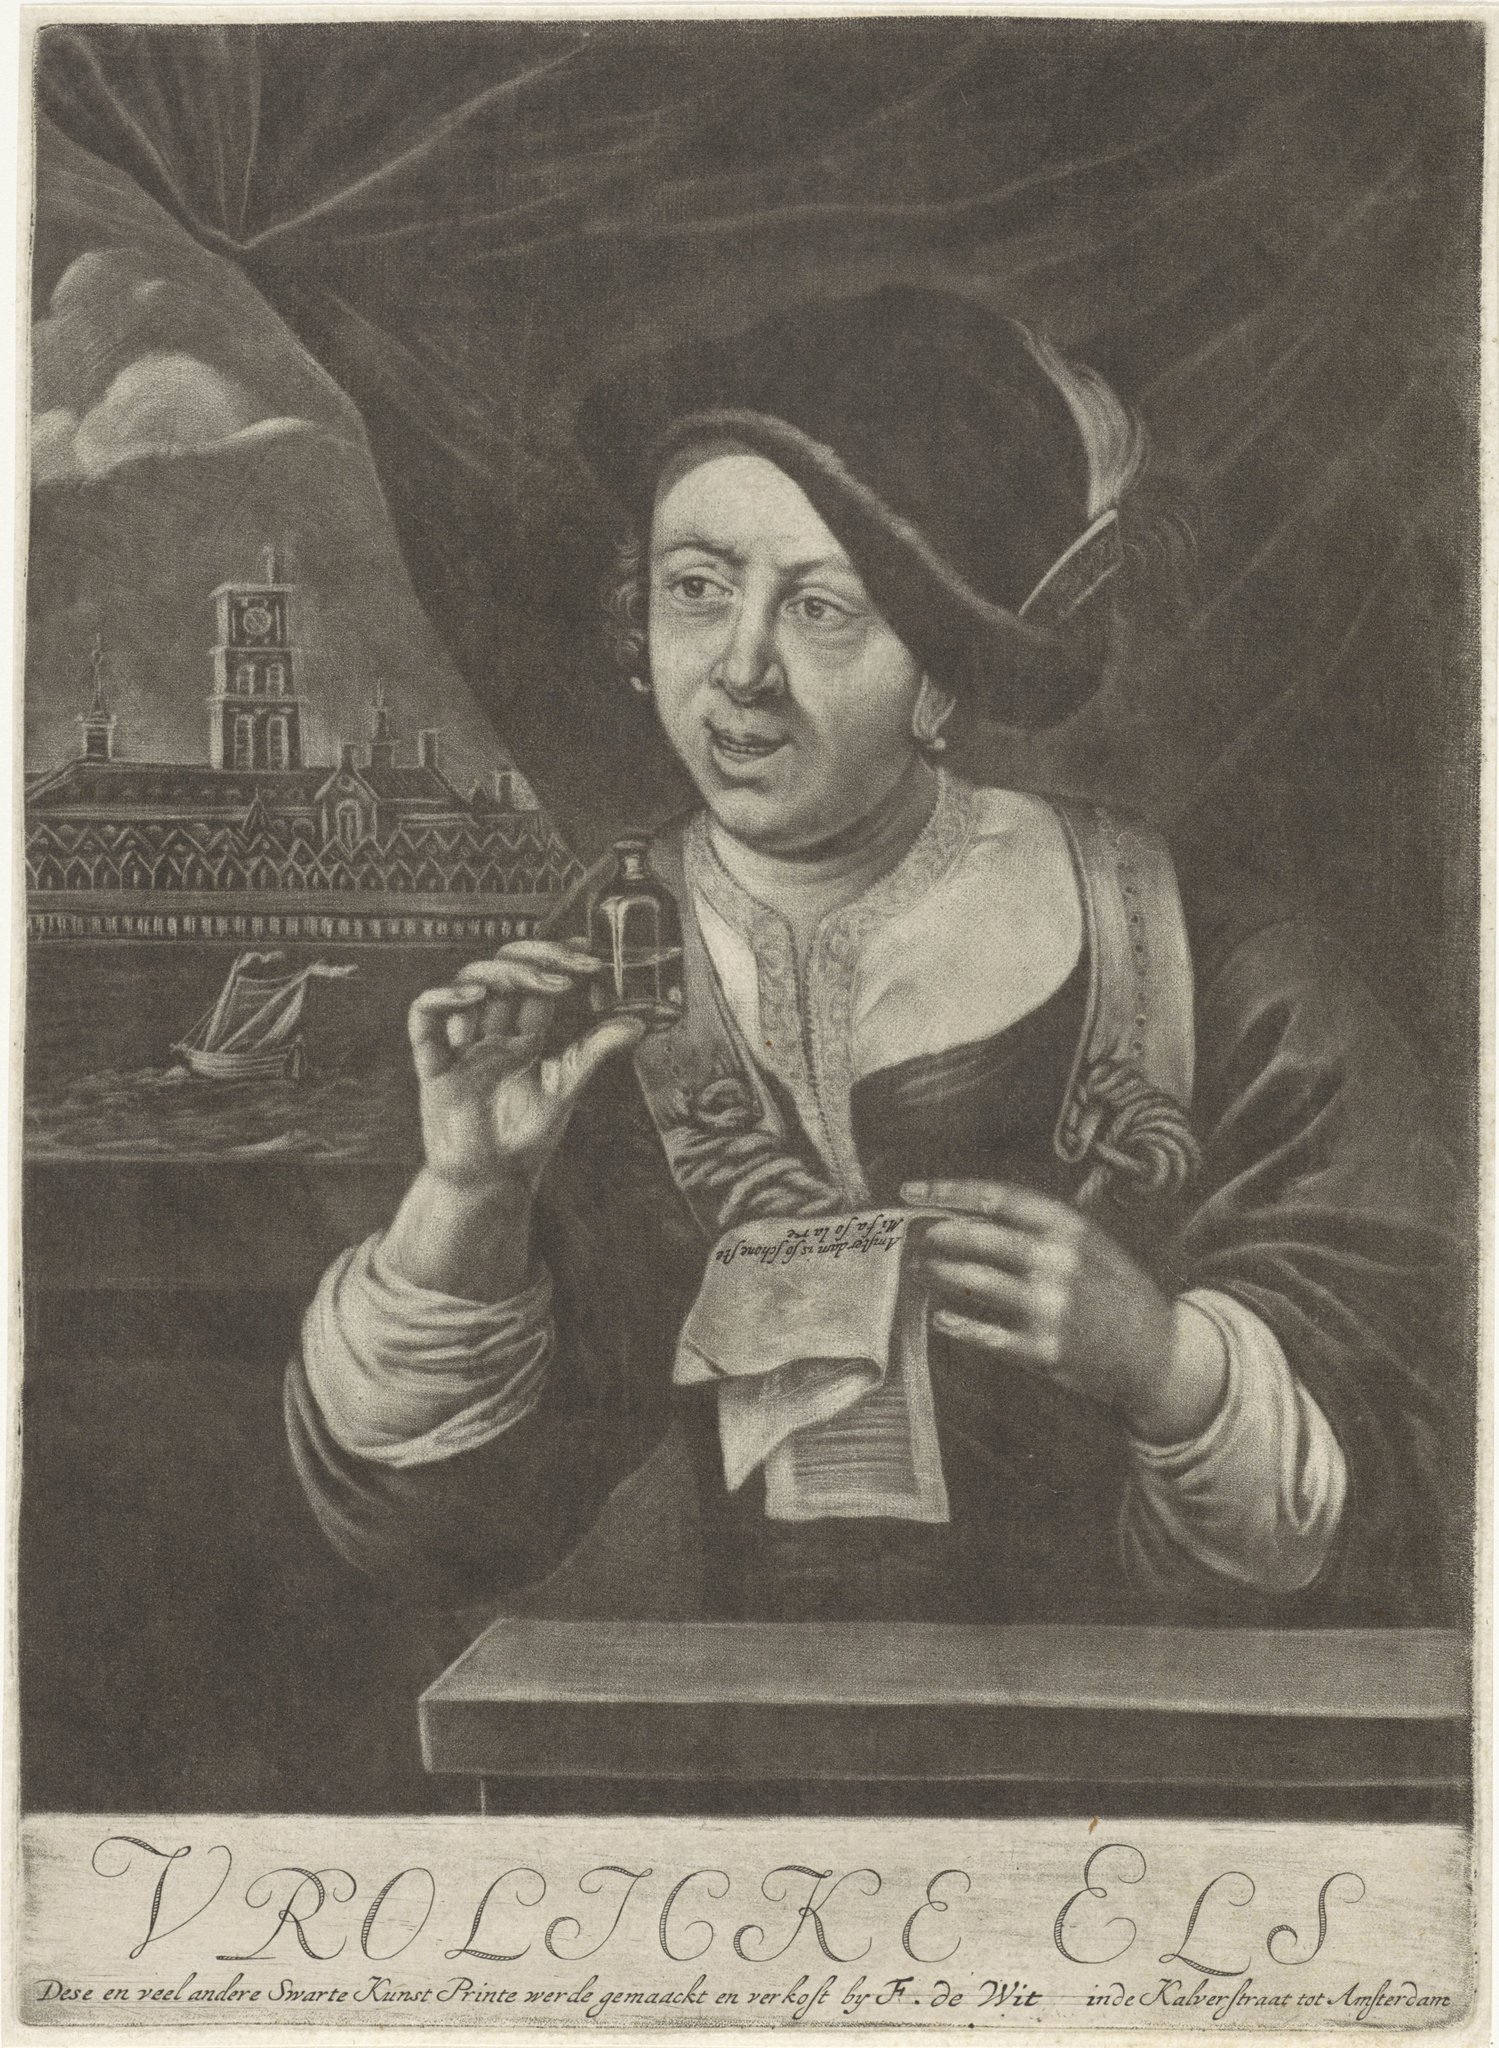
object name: print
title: Vrolicke Els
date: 1683-1706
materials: paper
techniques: mezzotint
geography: amsterdam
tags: city-view in general; 'veduta', river, vocal music, singing, drinking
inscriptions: collector's mark: Lugt 2228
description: 'Vrolijke Els' zingt van een blad waarop: Amsterdam is so schone ste/ Mi fa so la re. In haar hand heeft ze flacon. Op de achtergrond een rivier met een zeilschip waarachter een stad.